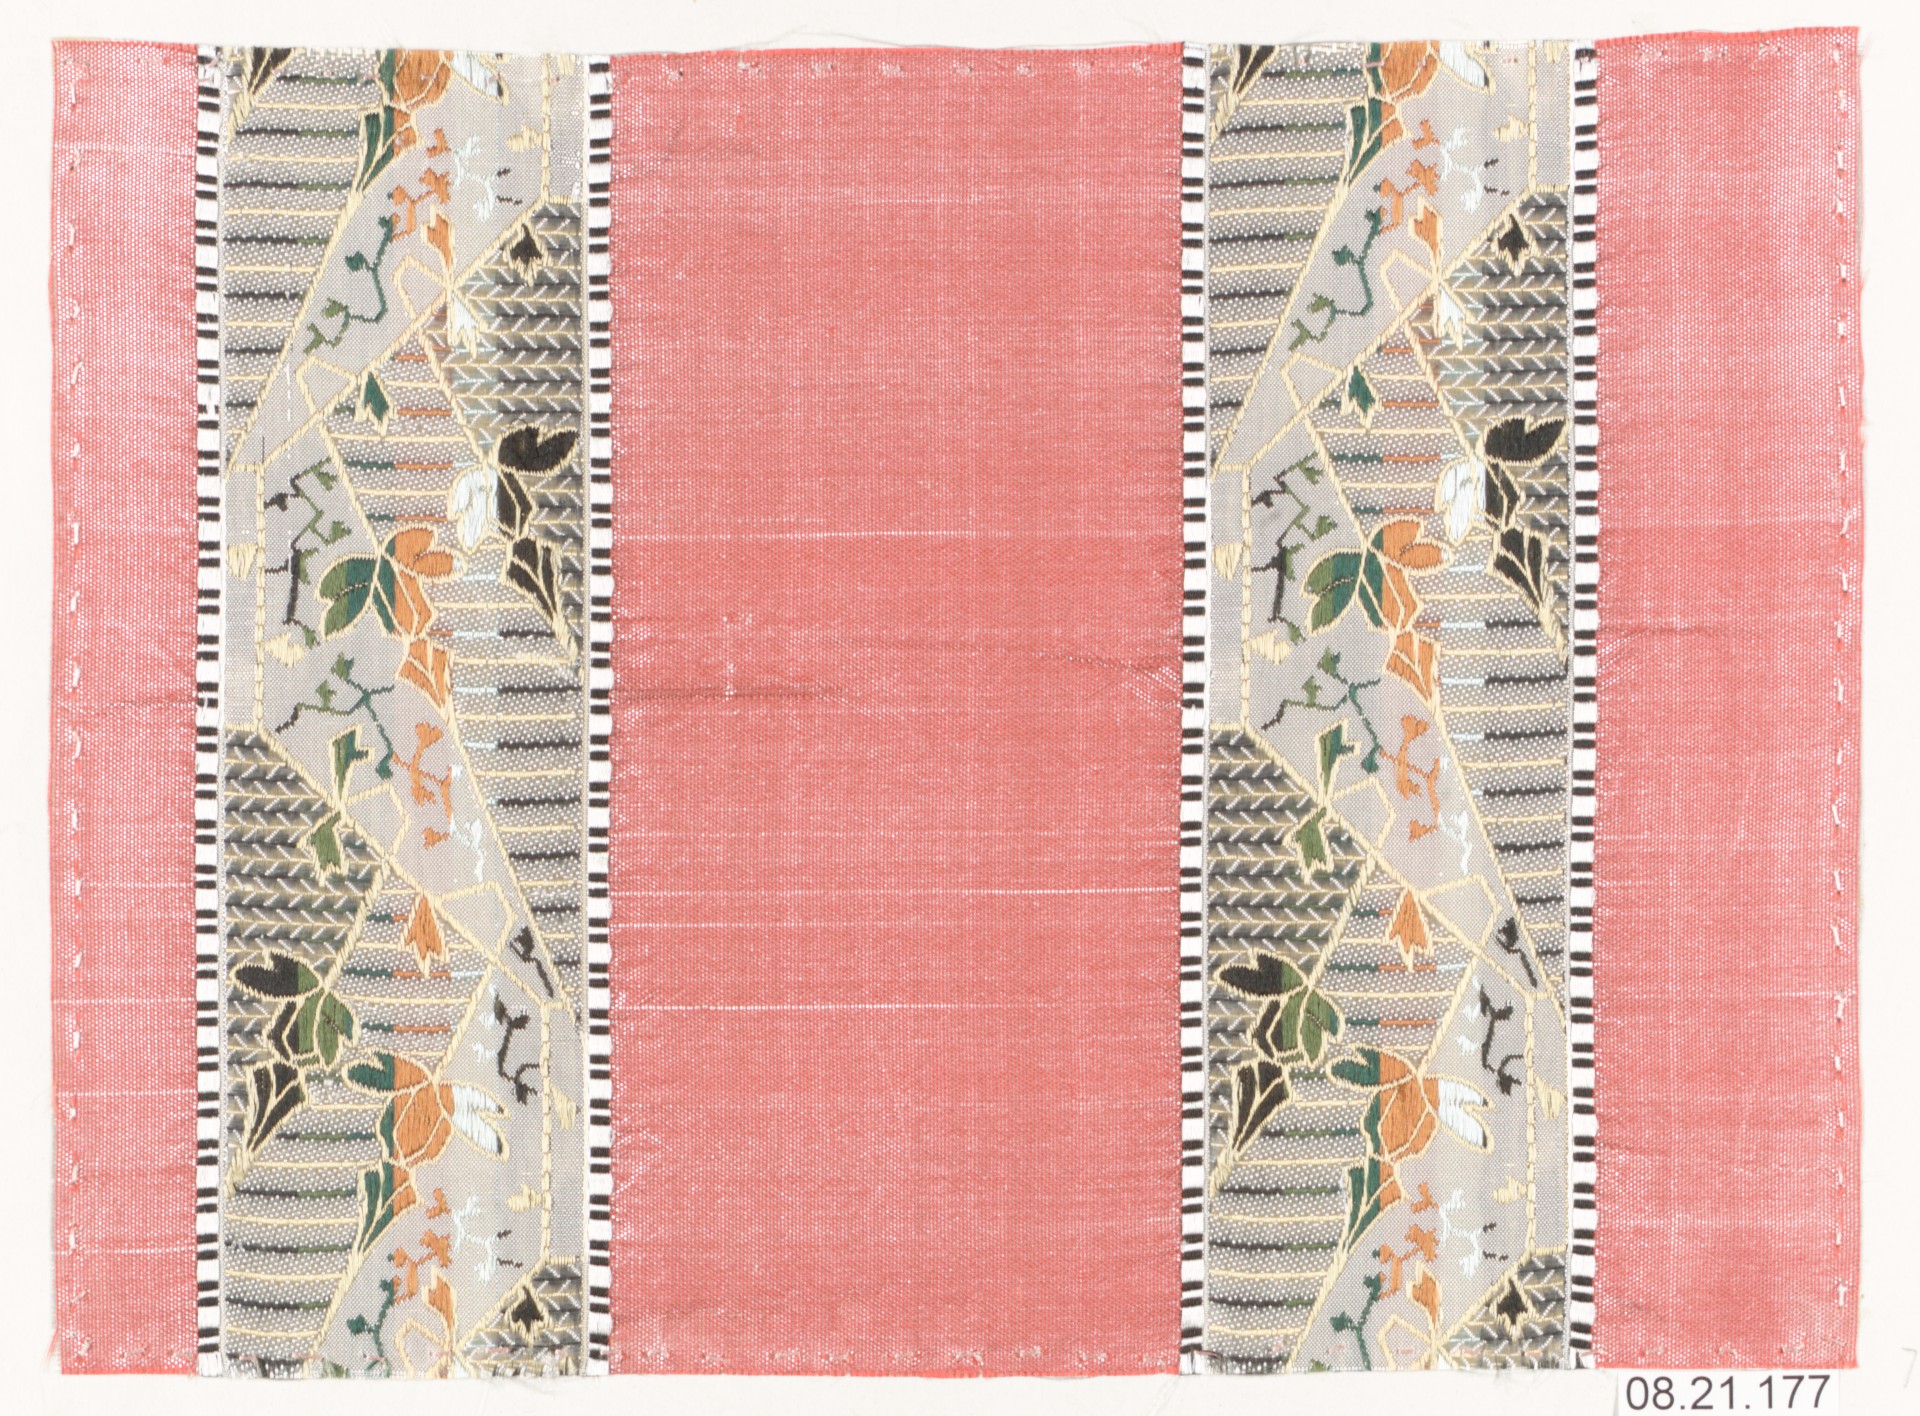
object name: textile sample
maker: Anonymous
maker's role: designer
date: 1900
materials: silk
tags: flowers